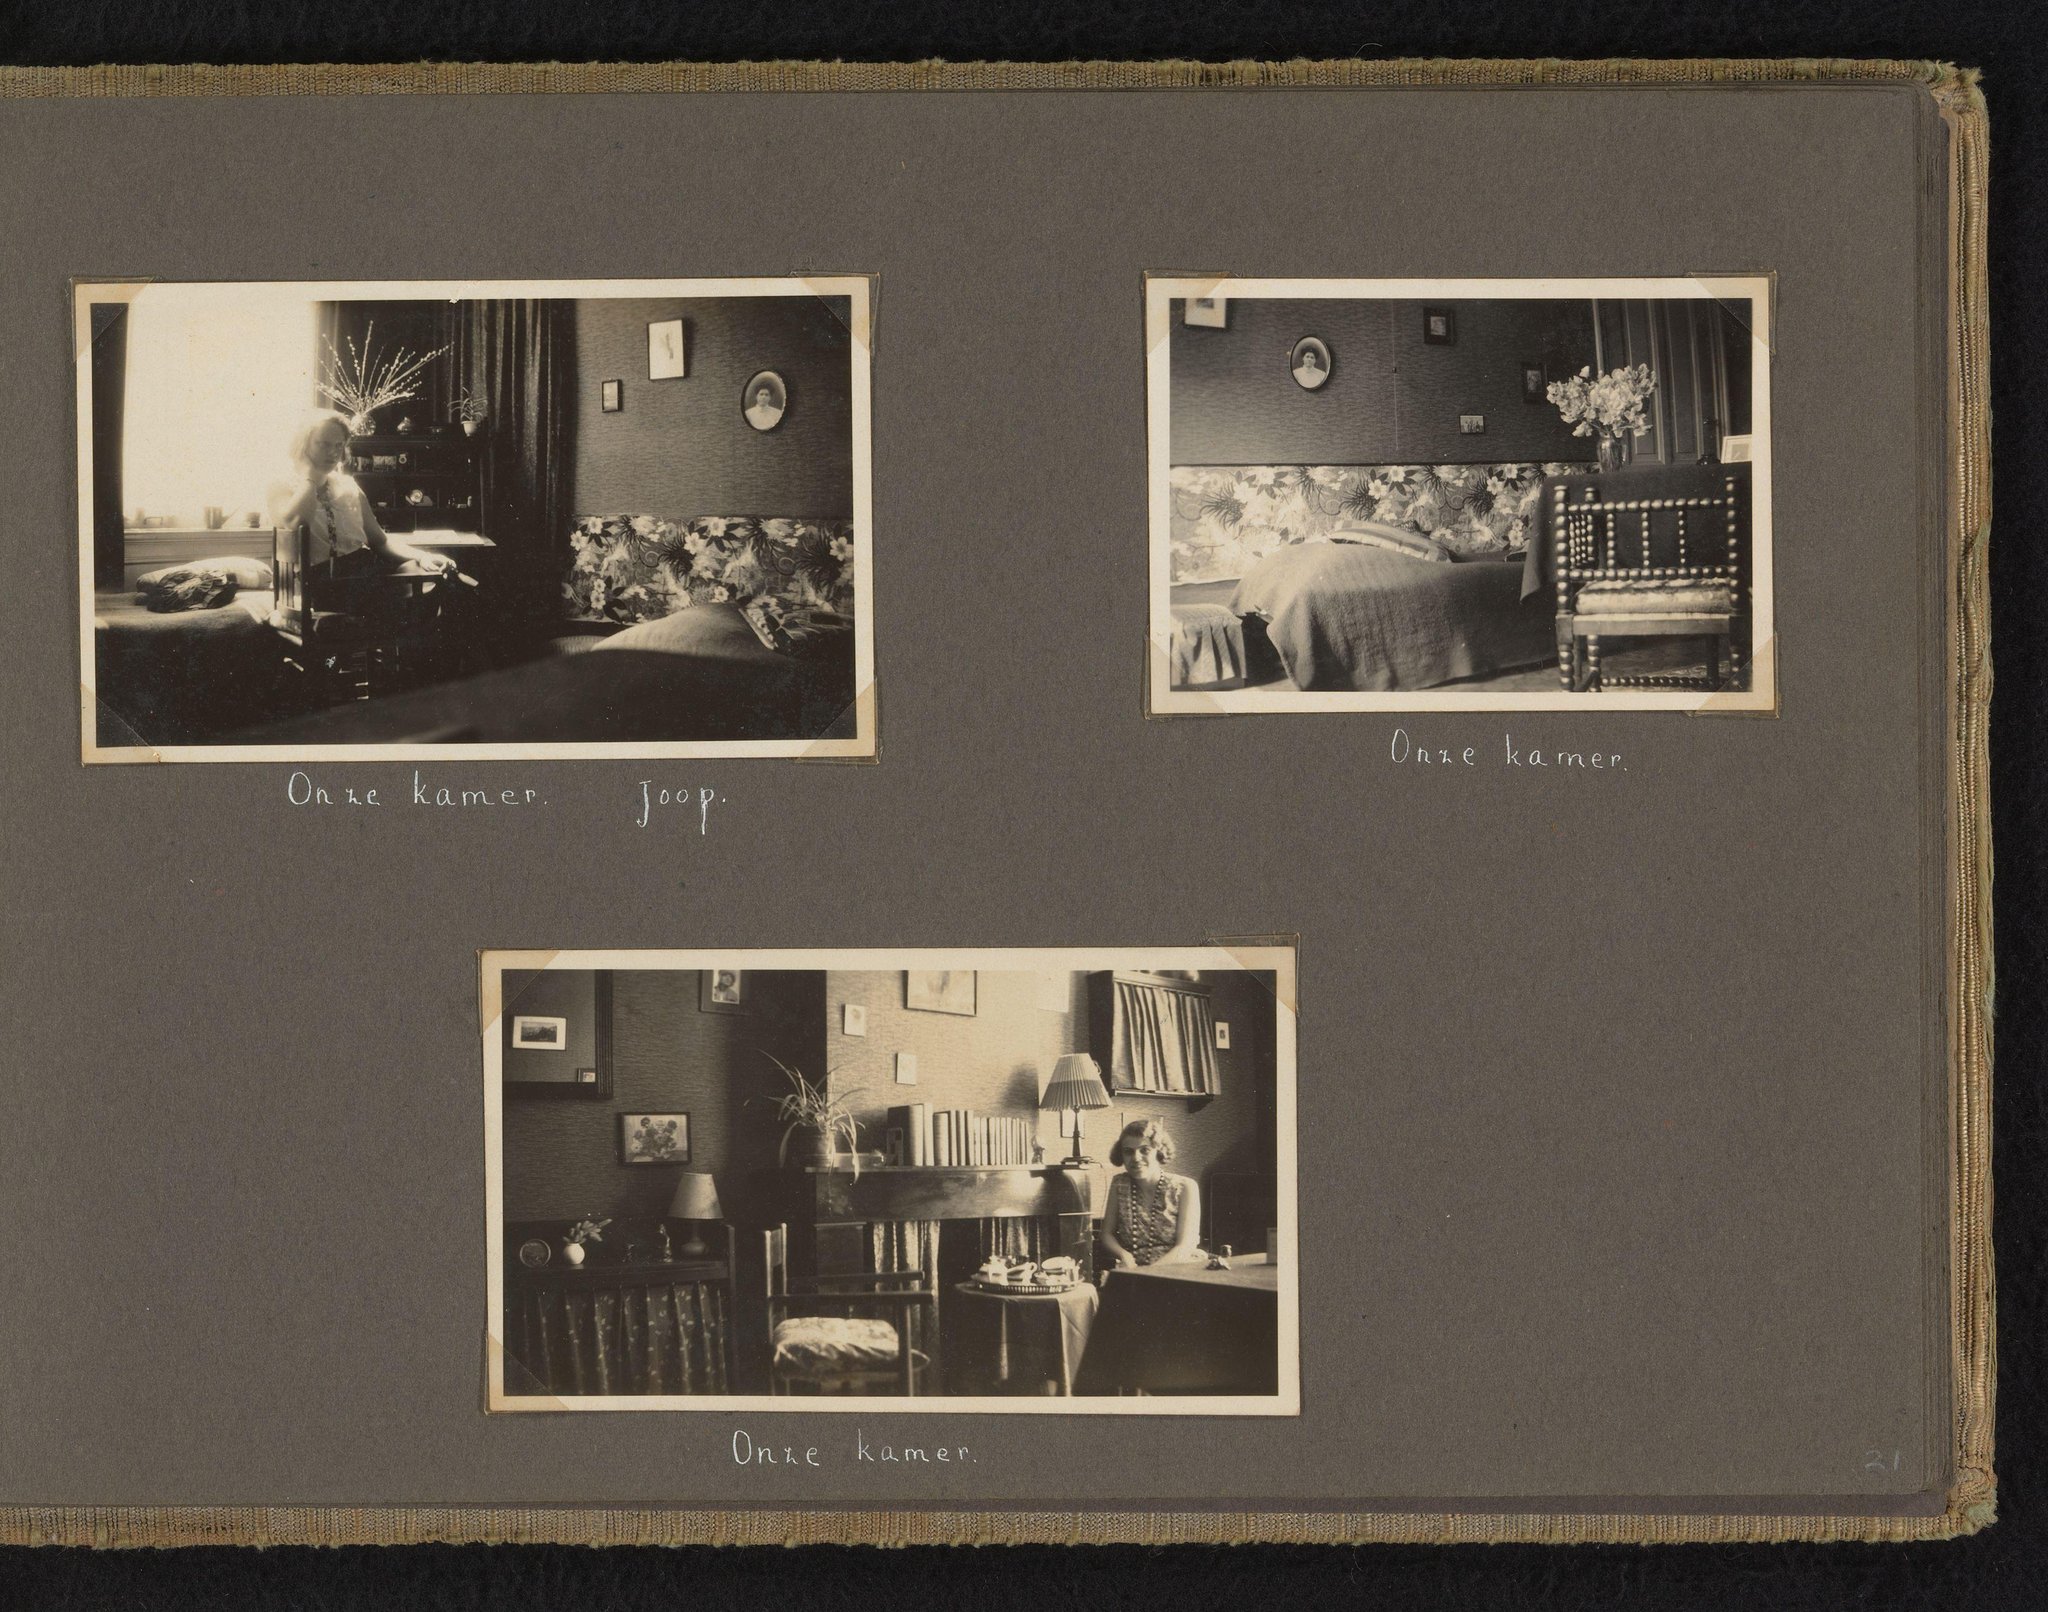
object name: photograph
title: Onze kamer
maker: Anonymous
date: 1930-1931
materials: cardboard, photographic support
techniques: gelatin silver print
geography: netherlands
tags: interior of the house, student life, netherlands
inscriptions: inscription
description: Albumblad met drie foto's van de gedeelde kamer van twee vriendinnen. Onderdeel van fotoalbum 'Studentenalbum Indologen'.